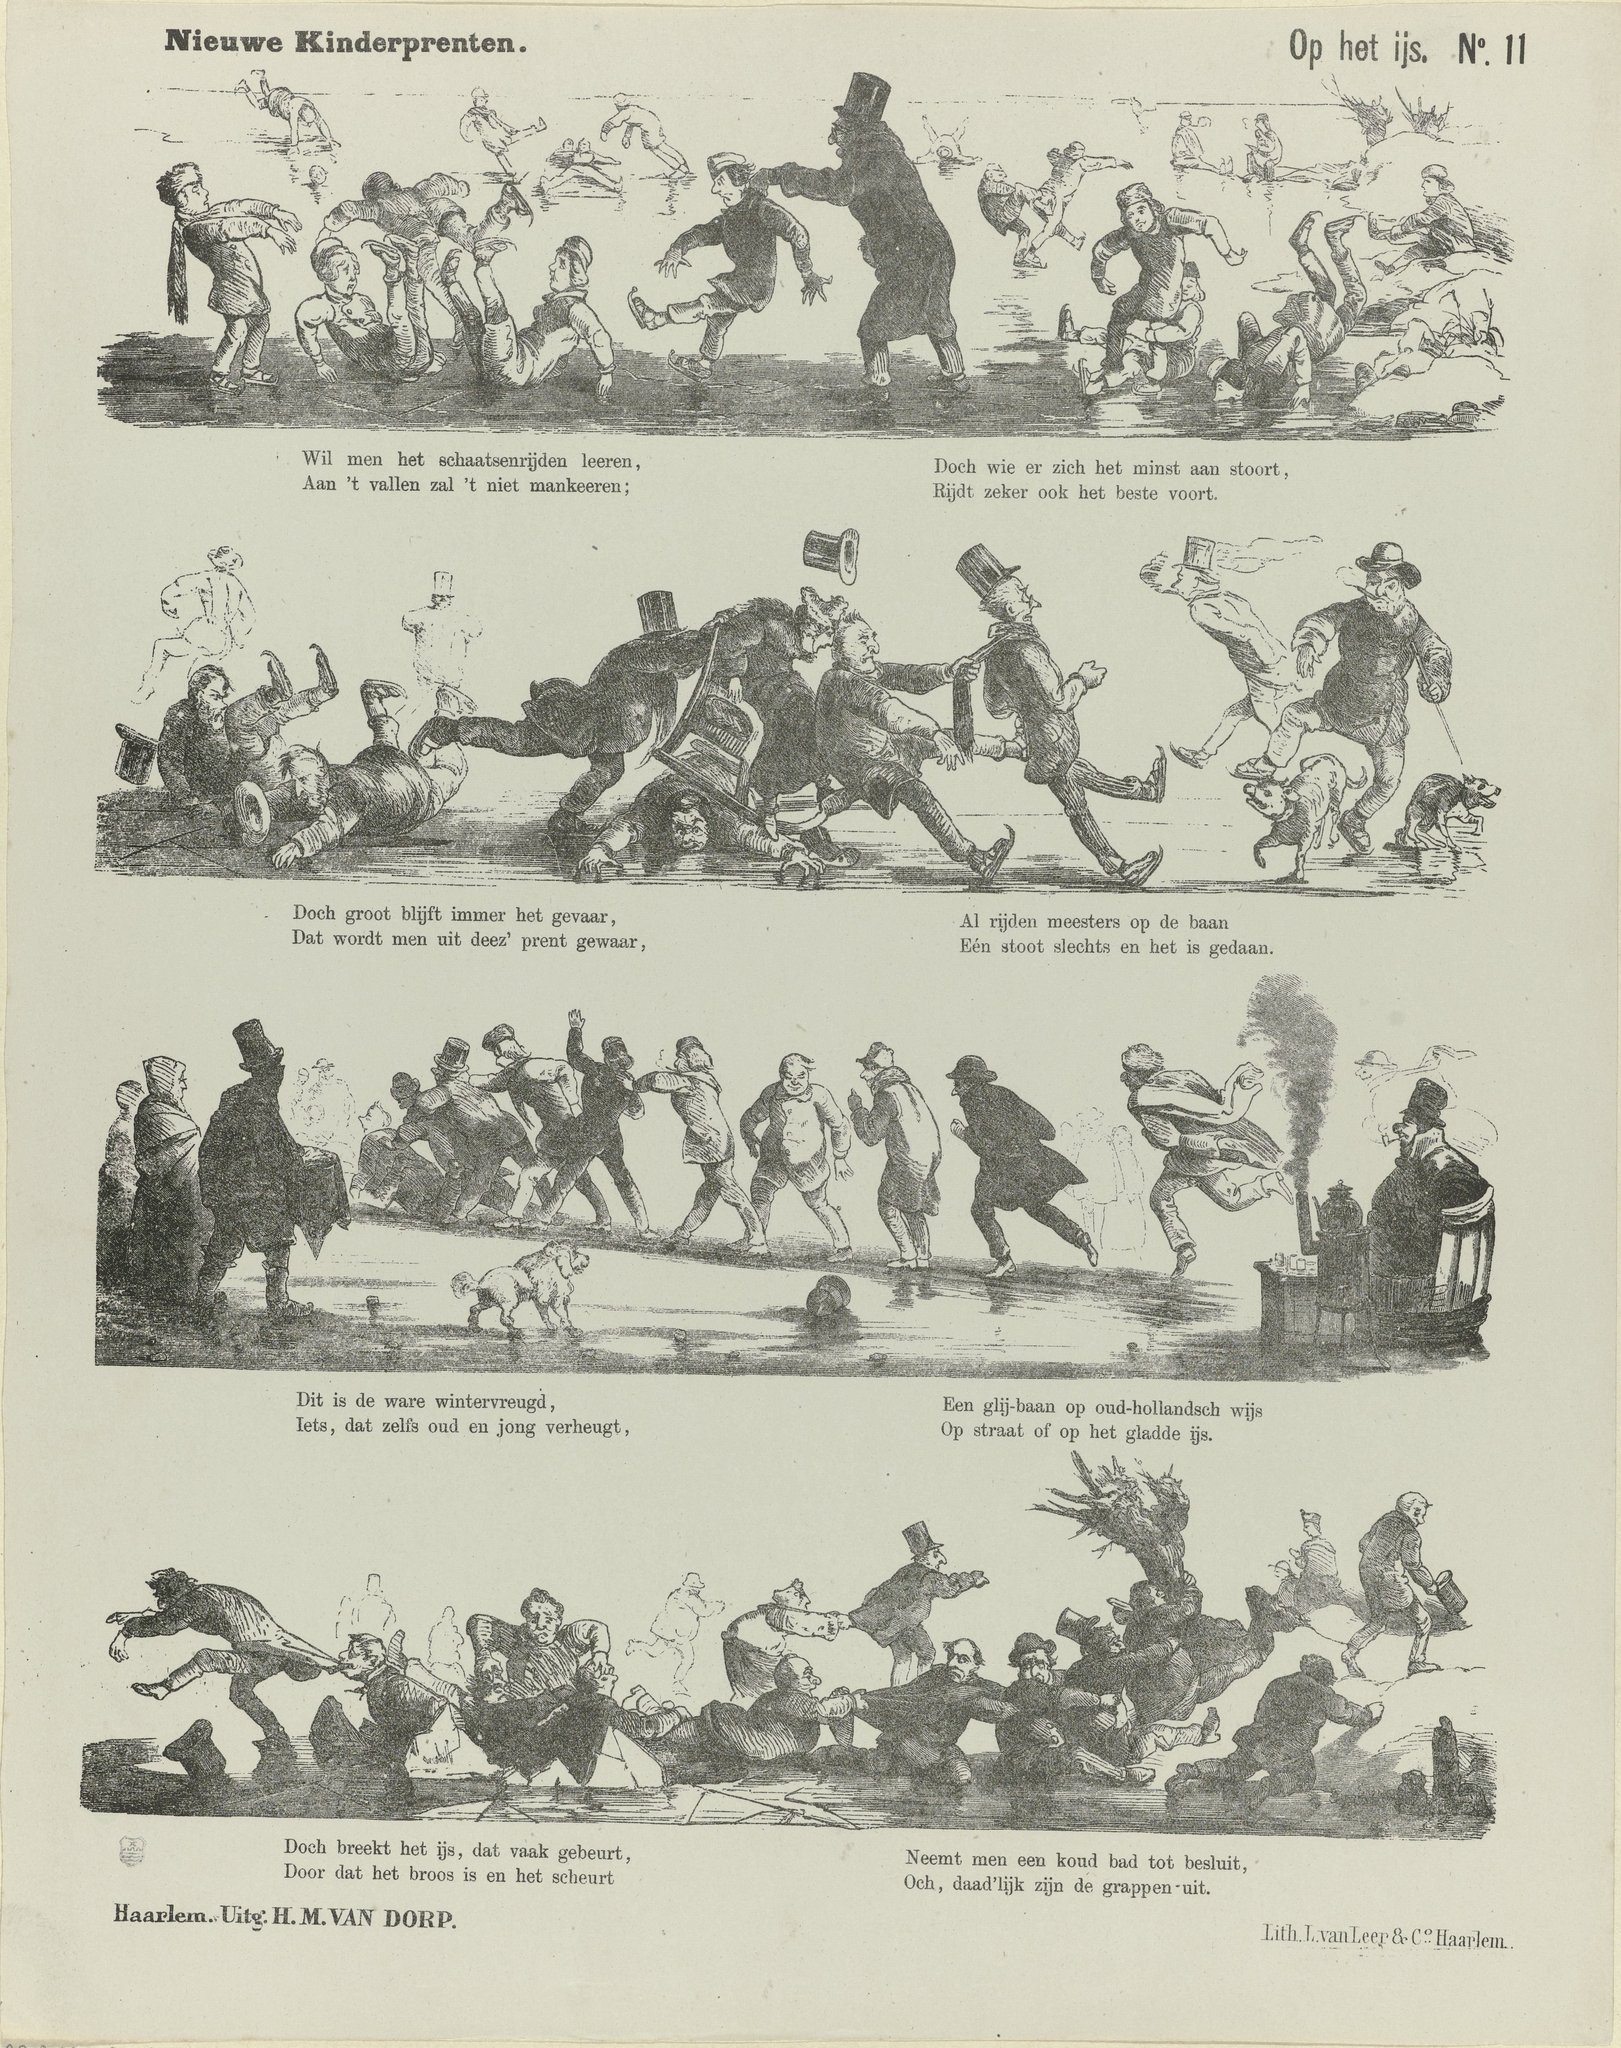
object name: popular print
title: Nieuwe kinderprenten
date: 1872-1883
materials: paper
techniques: letterpress printing, lithograph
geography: haarlem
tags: going through the ice ~ playing children, with chair on ice, skates (winter sports)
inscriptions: collector's mark: Lugt 2760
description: Blad met 4 horizontale rijen met voorstellingen van komische wintertaferelen waarbij aan het slot iedereen door het ijs zakt. Onder elke voorstelling een vierregelig vers in twee kolommen. Genummerd rechtsboven: No. 11.